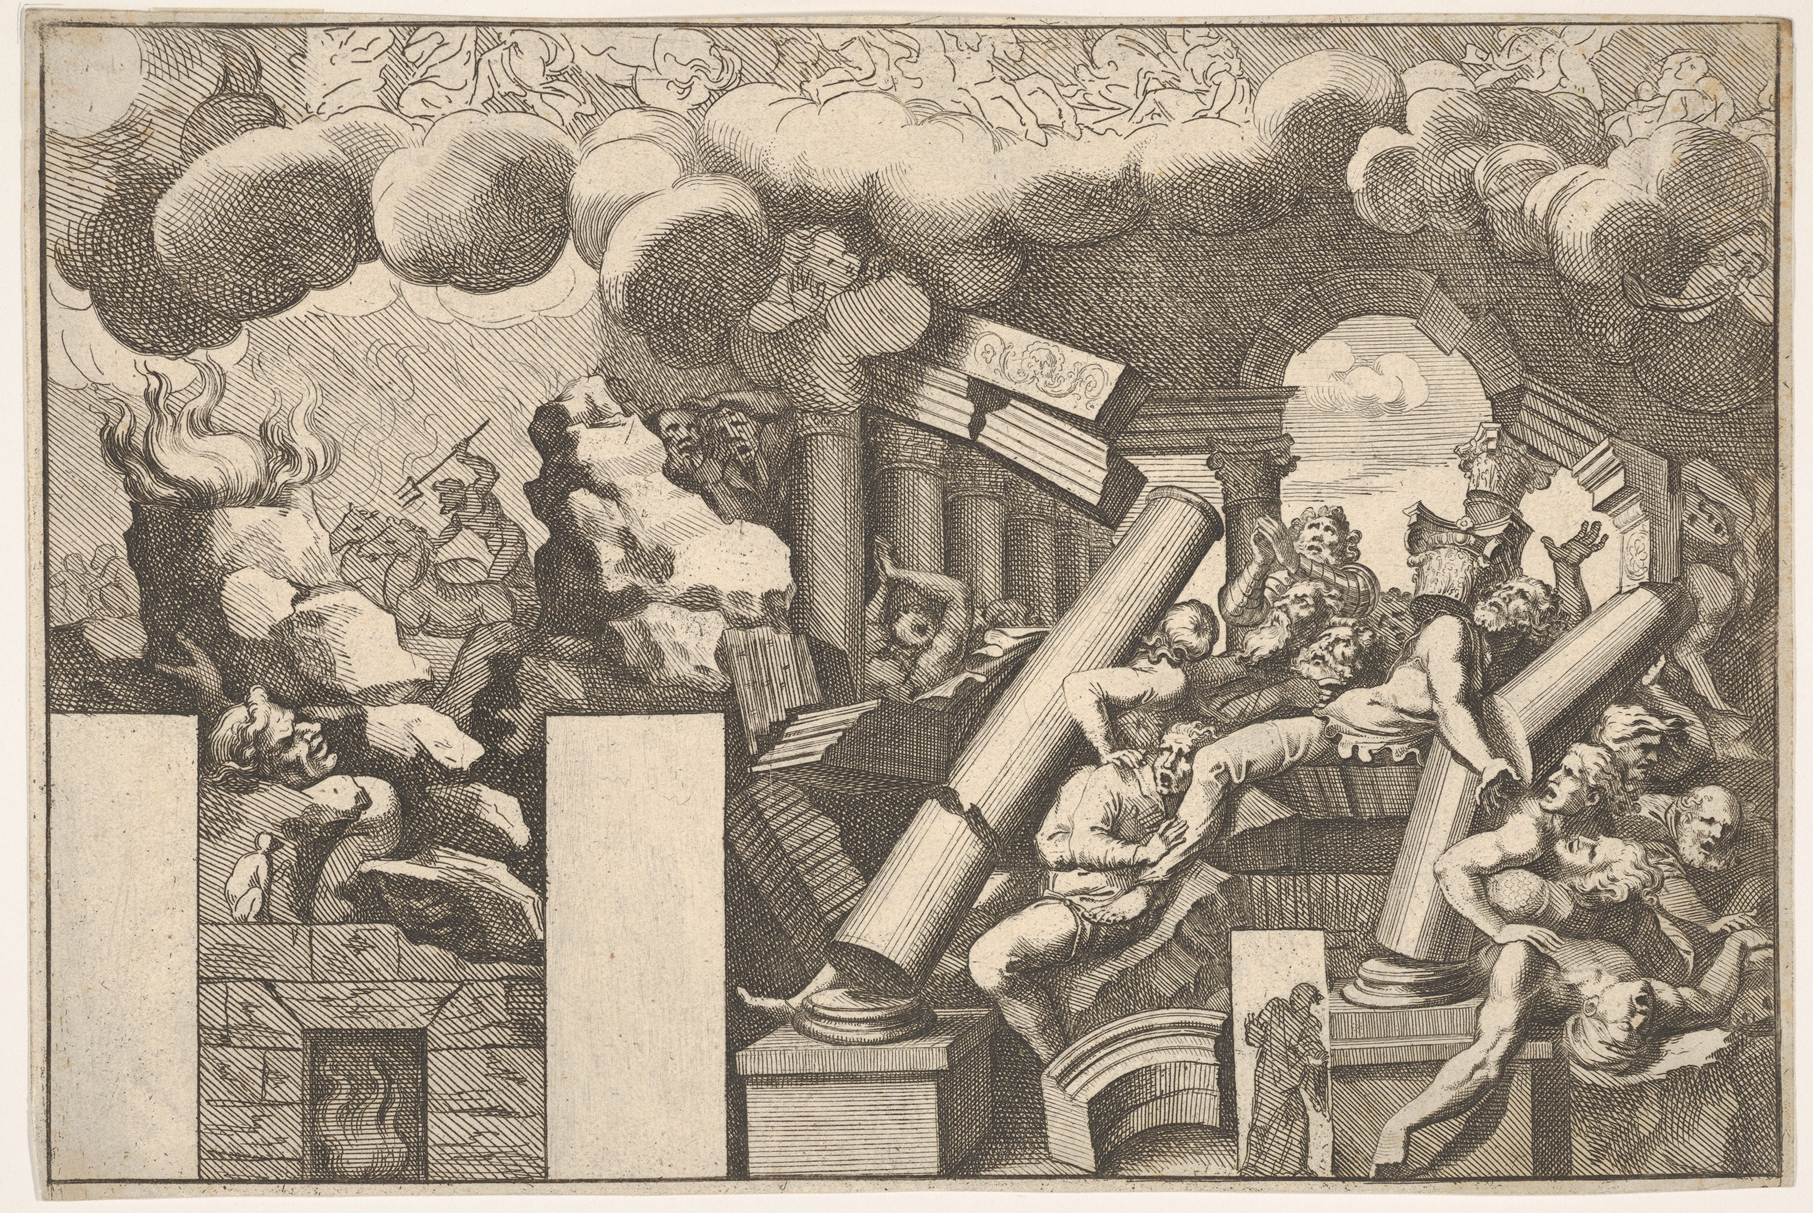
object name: print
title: Giants crushed by rocks and the falling columns of the temple, clouds of smoke above, Poseidon in his chariot to left in the background, two spaces at left for doorways, from "Giove che fulmina li giganti", after the frescoes on the ceiling of the Sala dei Giganti designed by Giulio Romano for the Palazzo del Te, Mantua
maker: pietro santi bartoli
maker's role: artist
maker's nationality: italian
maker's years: 1615-1700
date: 1680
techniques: etching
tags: columns,crowd